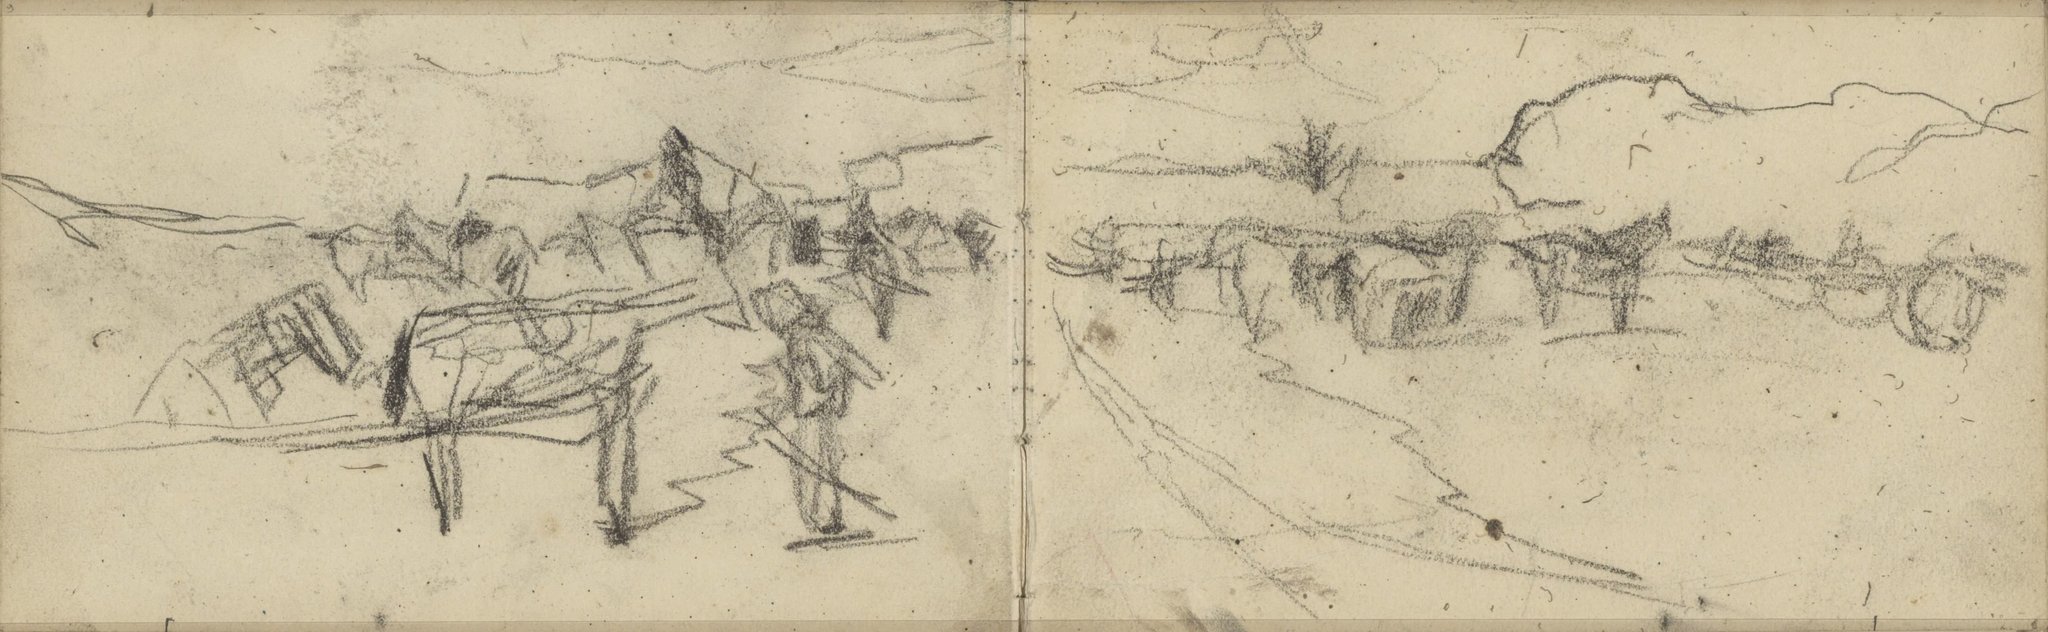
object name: sketchbook leaf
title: Bereden artilleristen in een park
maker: george hendrik breitner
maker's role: draughtsman, painter, print maker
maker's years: 1857-1923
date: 1884-1886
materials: chalk, paper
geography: the hague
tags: park, land forces (+ artillery), horse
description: Pagina 9 en pagina 10 uit een schetsboek met 35 bladen.